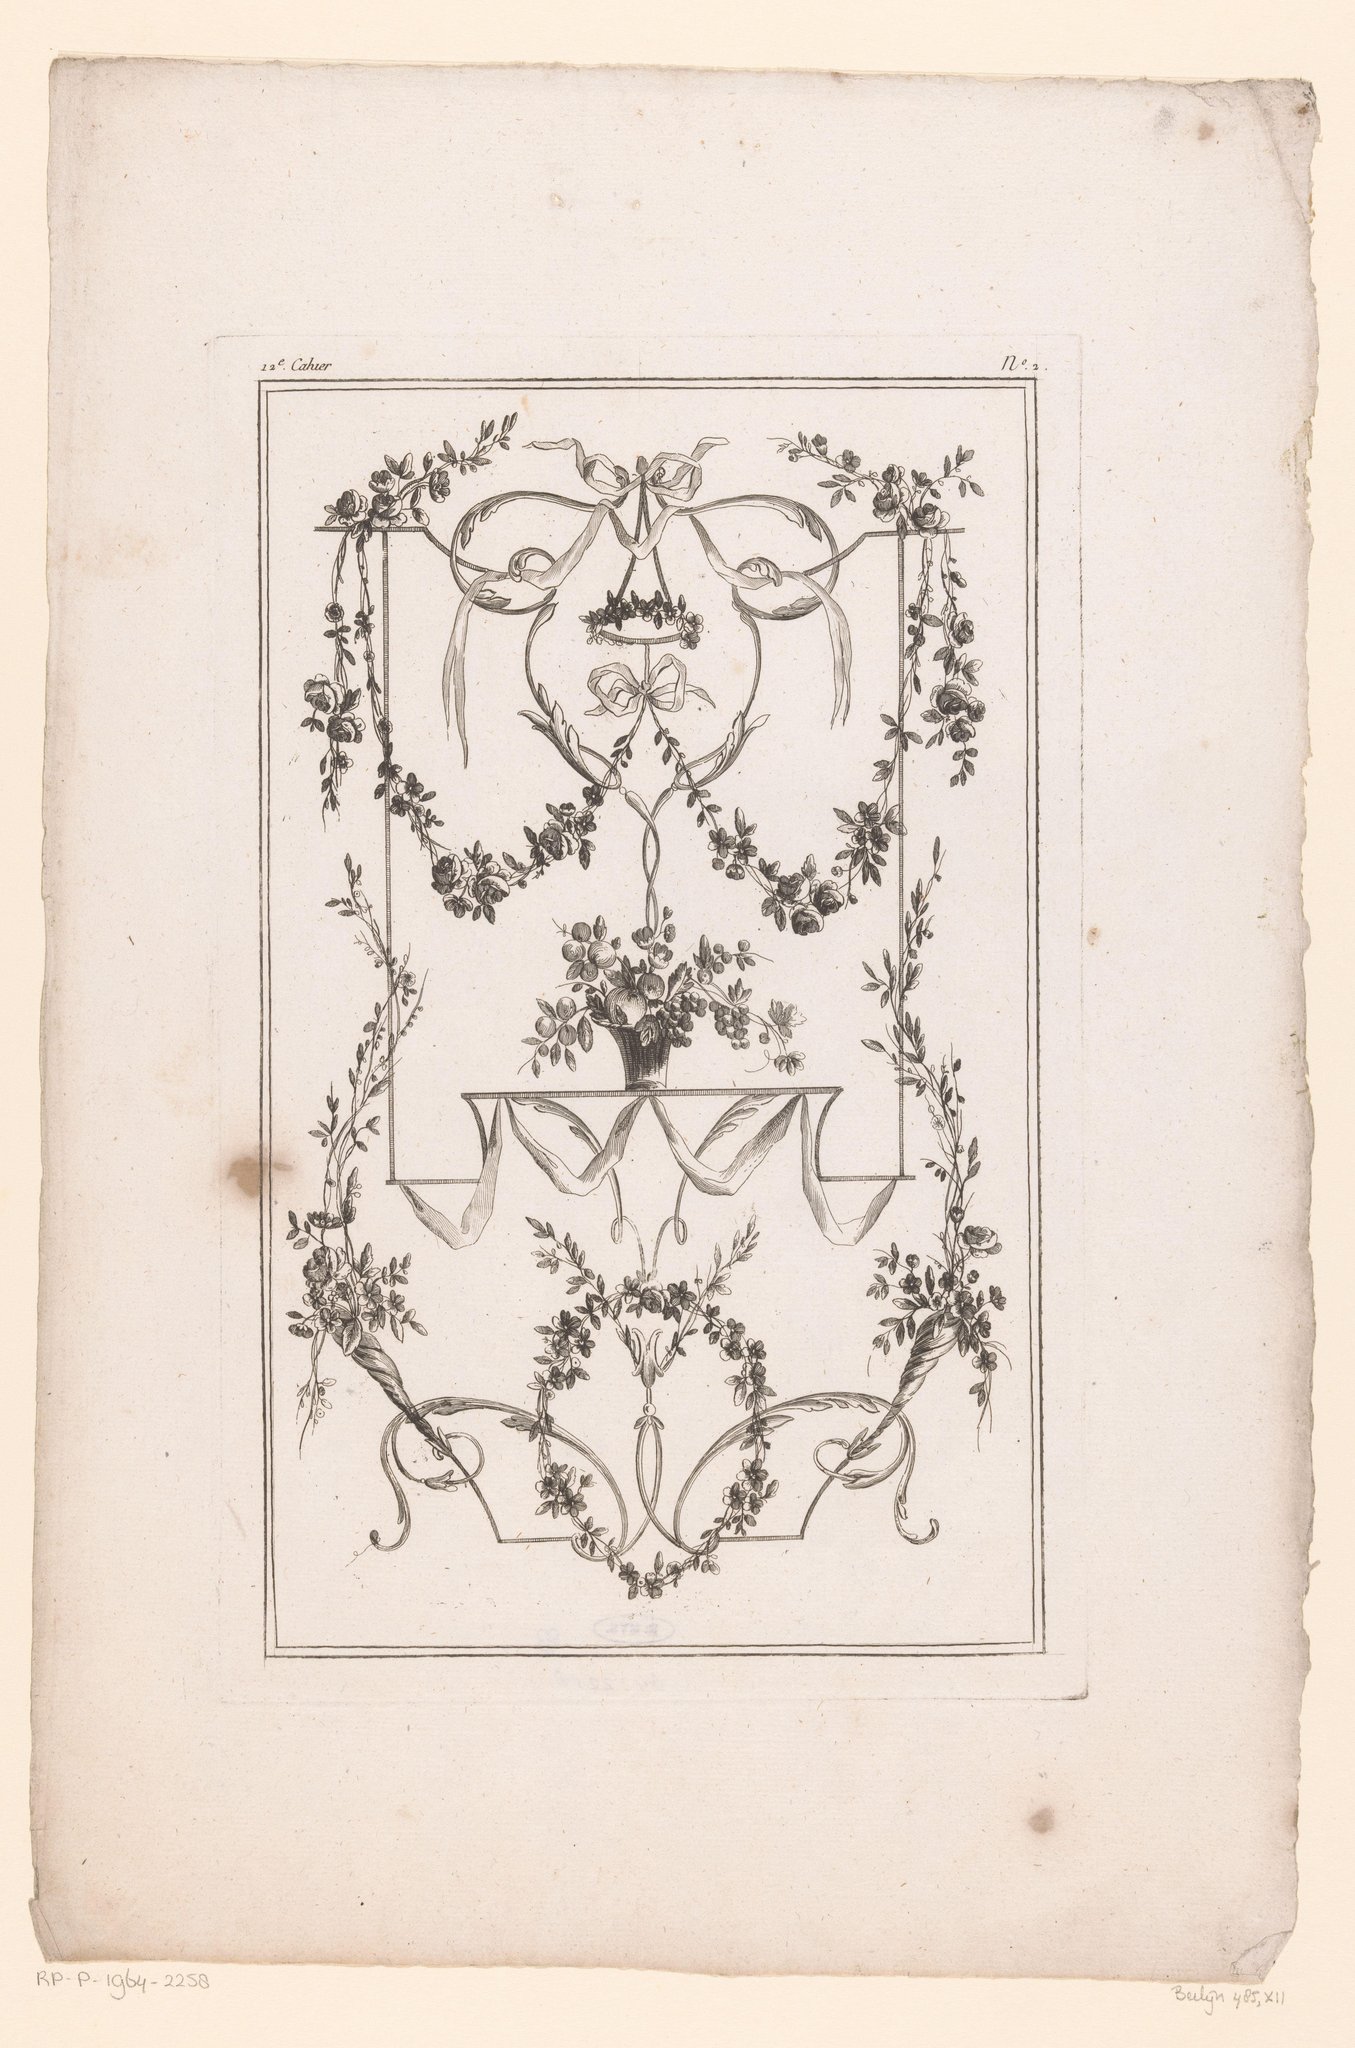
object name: ornament print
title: XII Cahier D'Ornement Pour la Boiserie d'Appartement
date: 1777-1779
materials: paper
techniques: etching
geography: rouen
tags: panelling, bunch of flowers ~ ornament, container made of plant material other than wood: basket, bow (ornamental part of clothing)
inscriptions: collector's mark: Lugt 2760, collector's mark: Lugt 2228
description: Een paneel met bloemranken, strikken en een mand met bloemen.